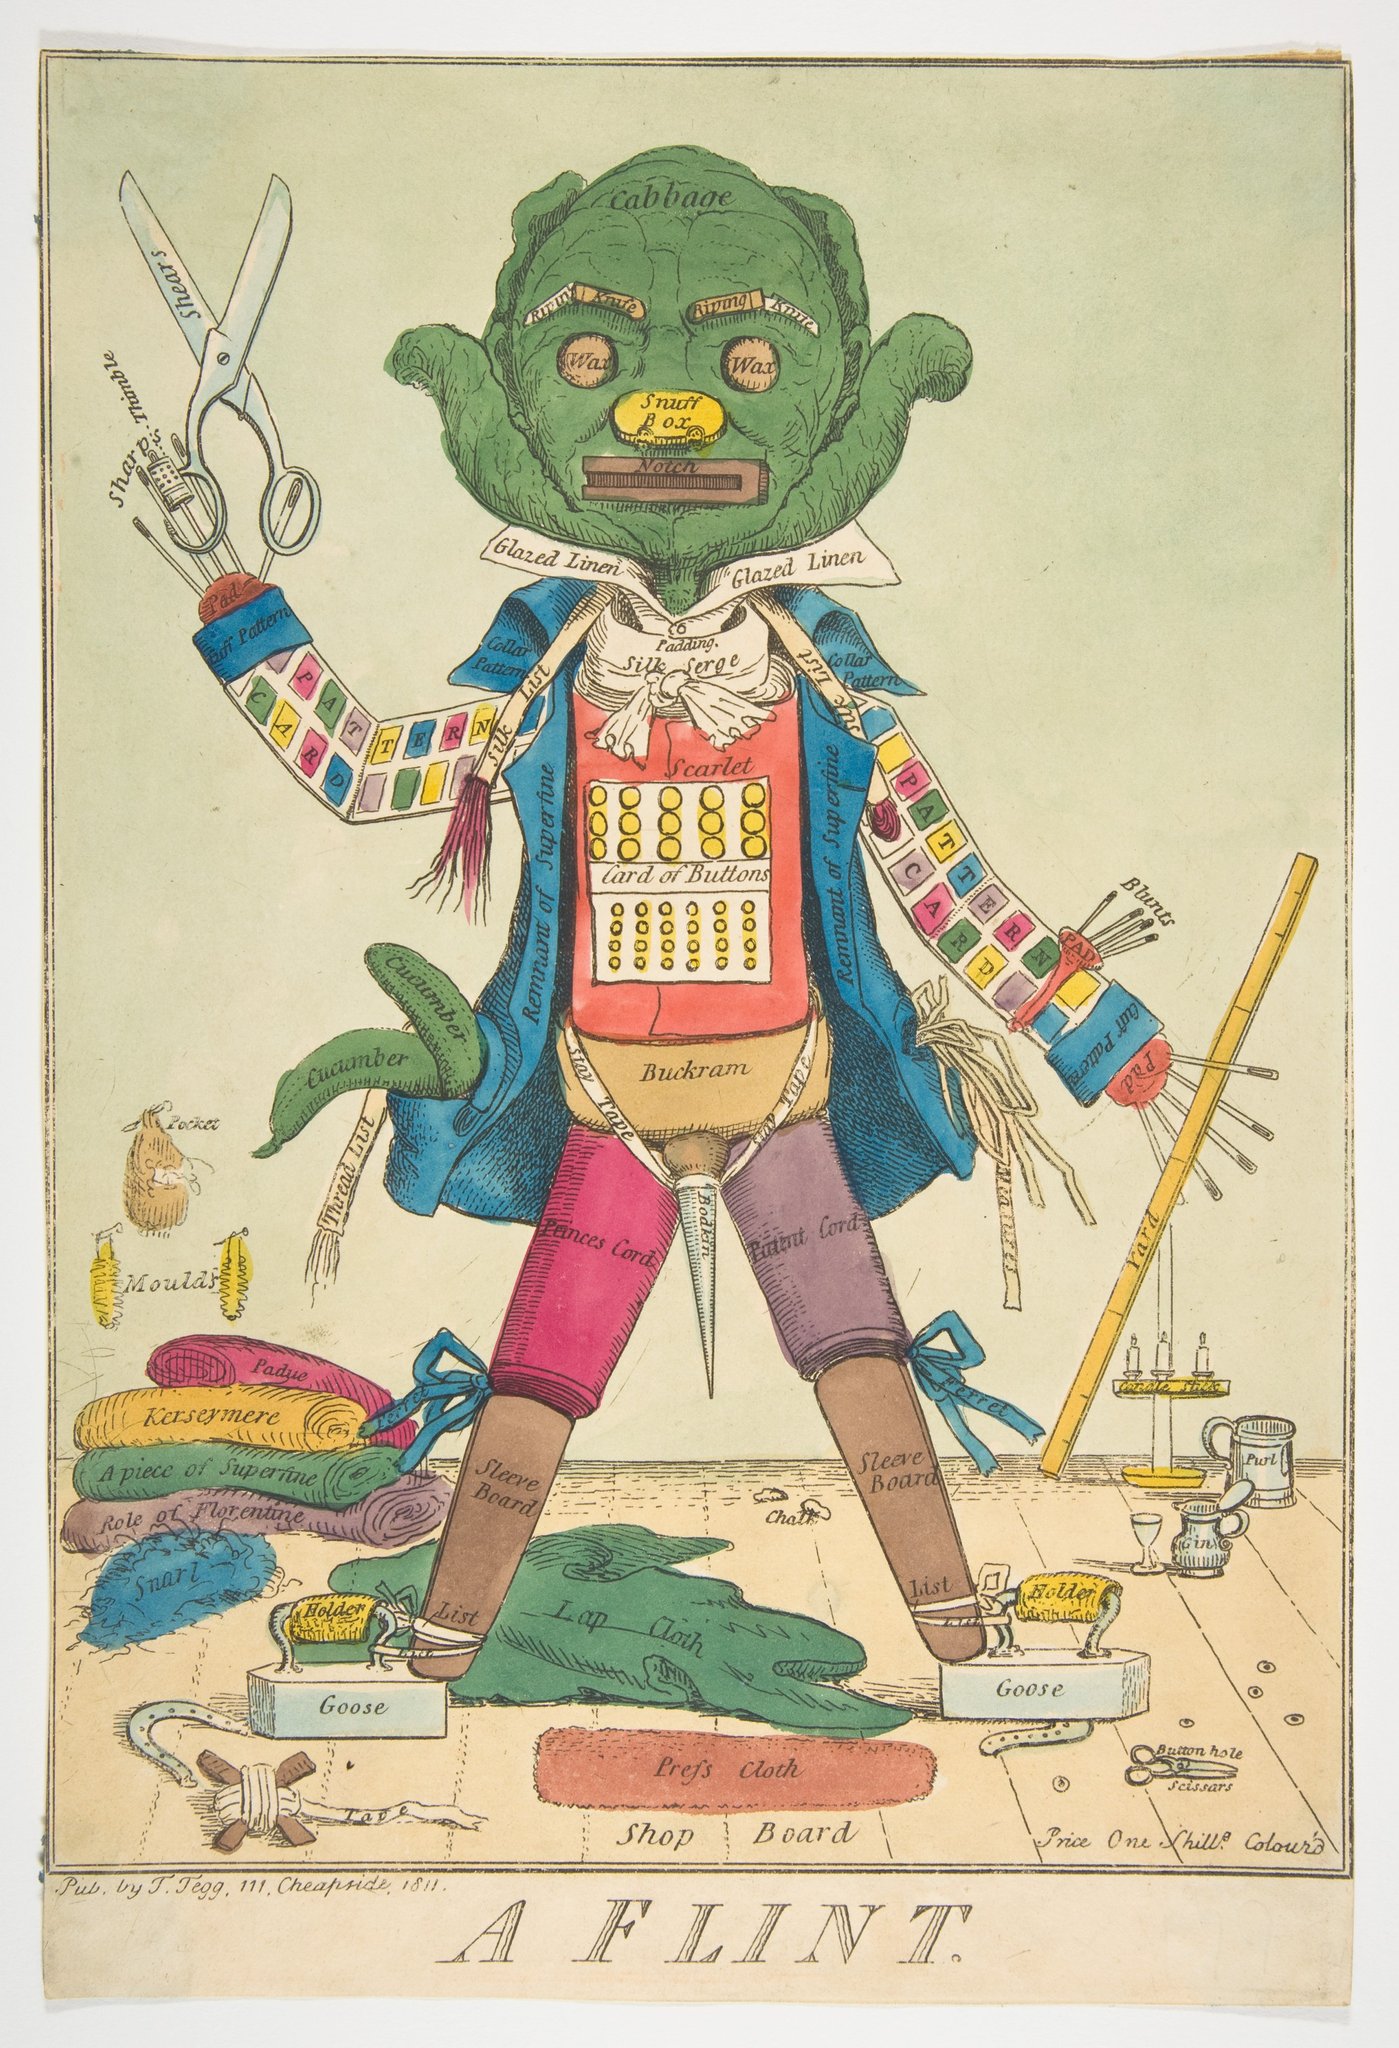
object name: print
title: A Flint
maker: anonymous, british, 19th century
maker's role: artist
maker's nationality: british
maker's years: 1800-1900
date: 1811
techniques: etching